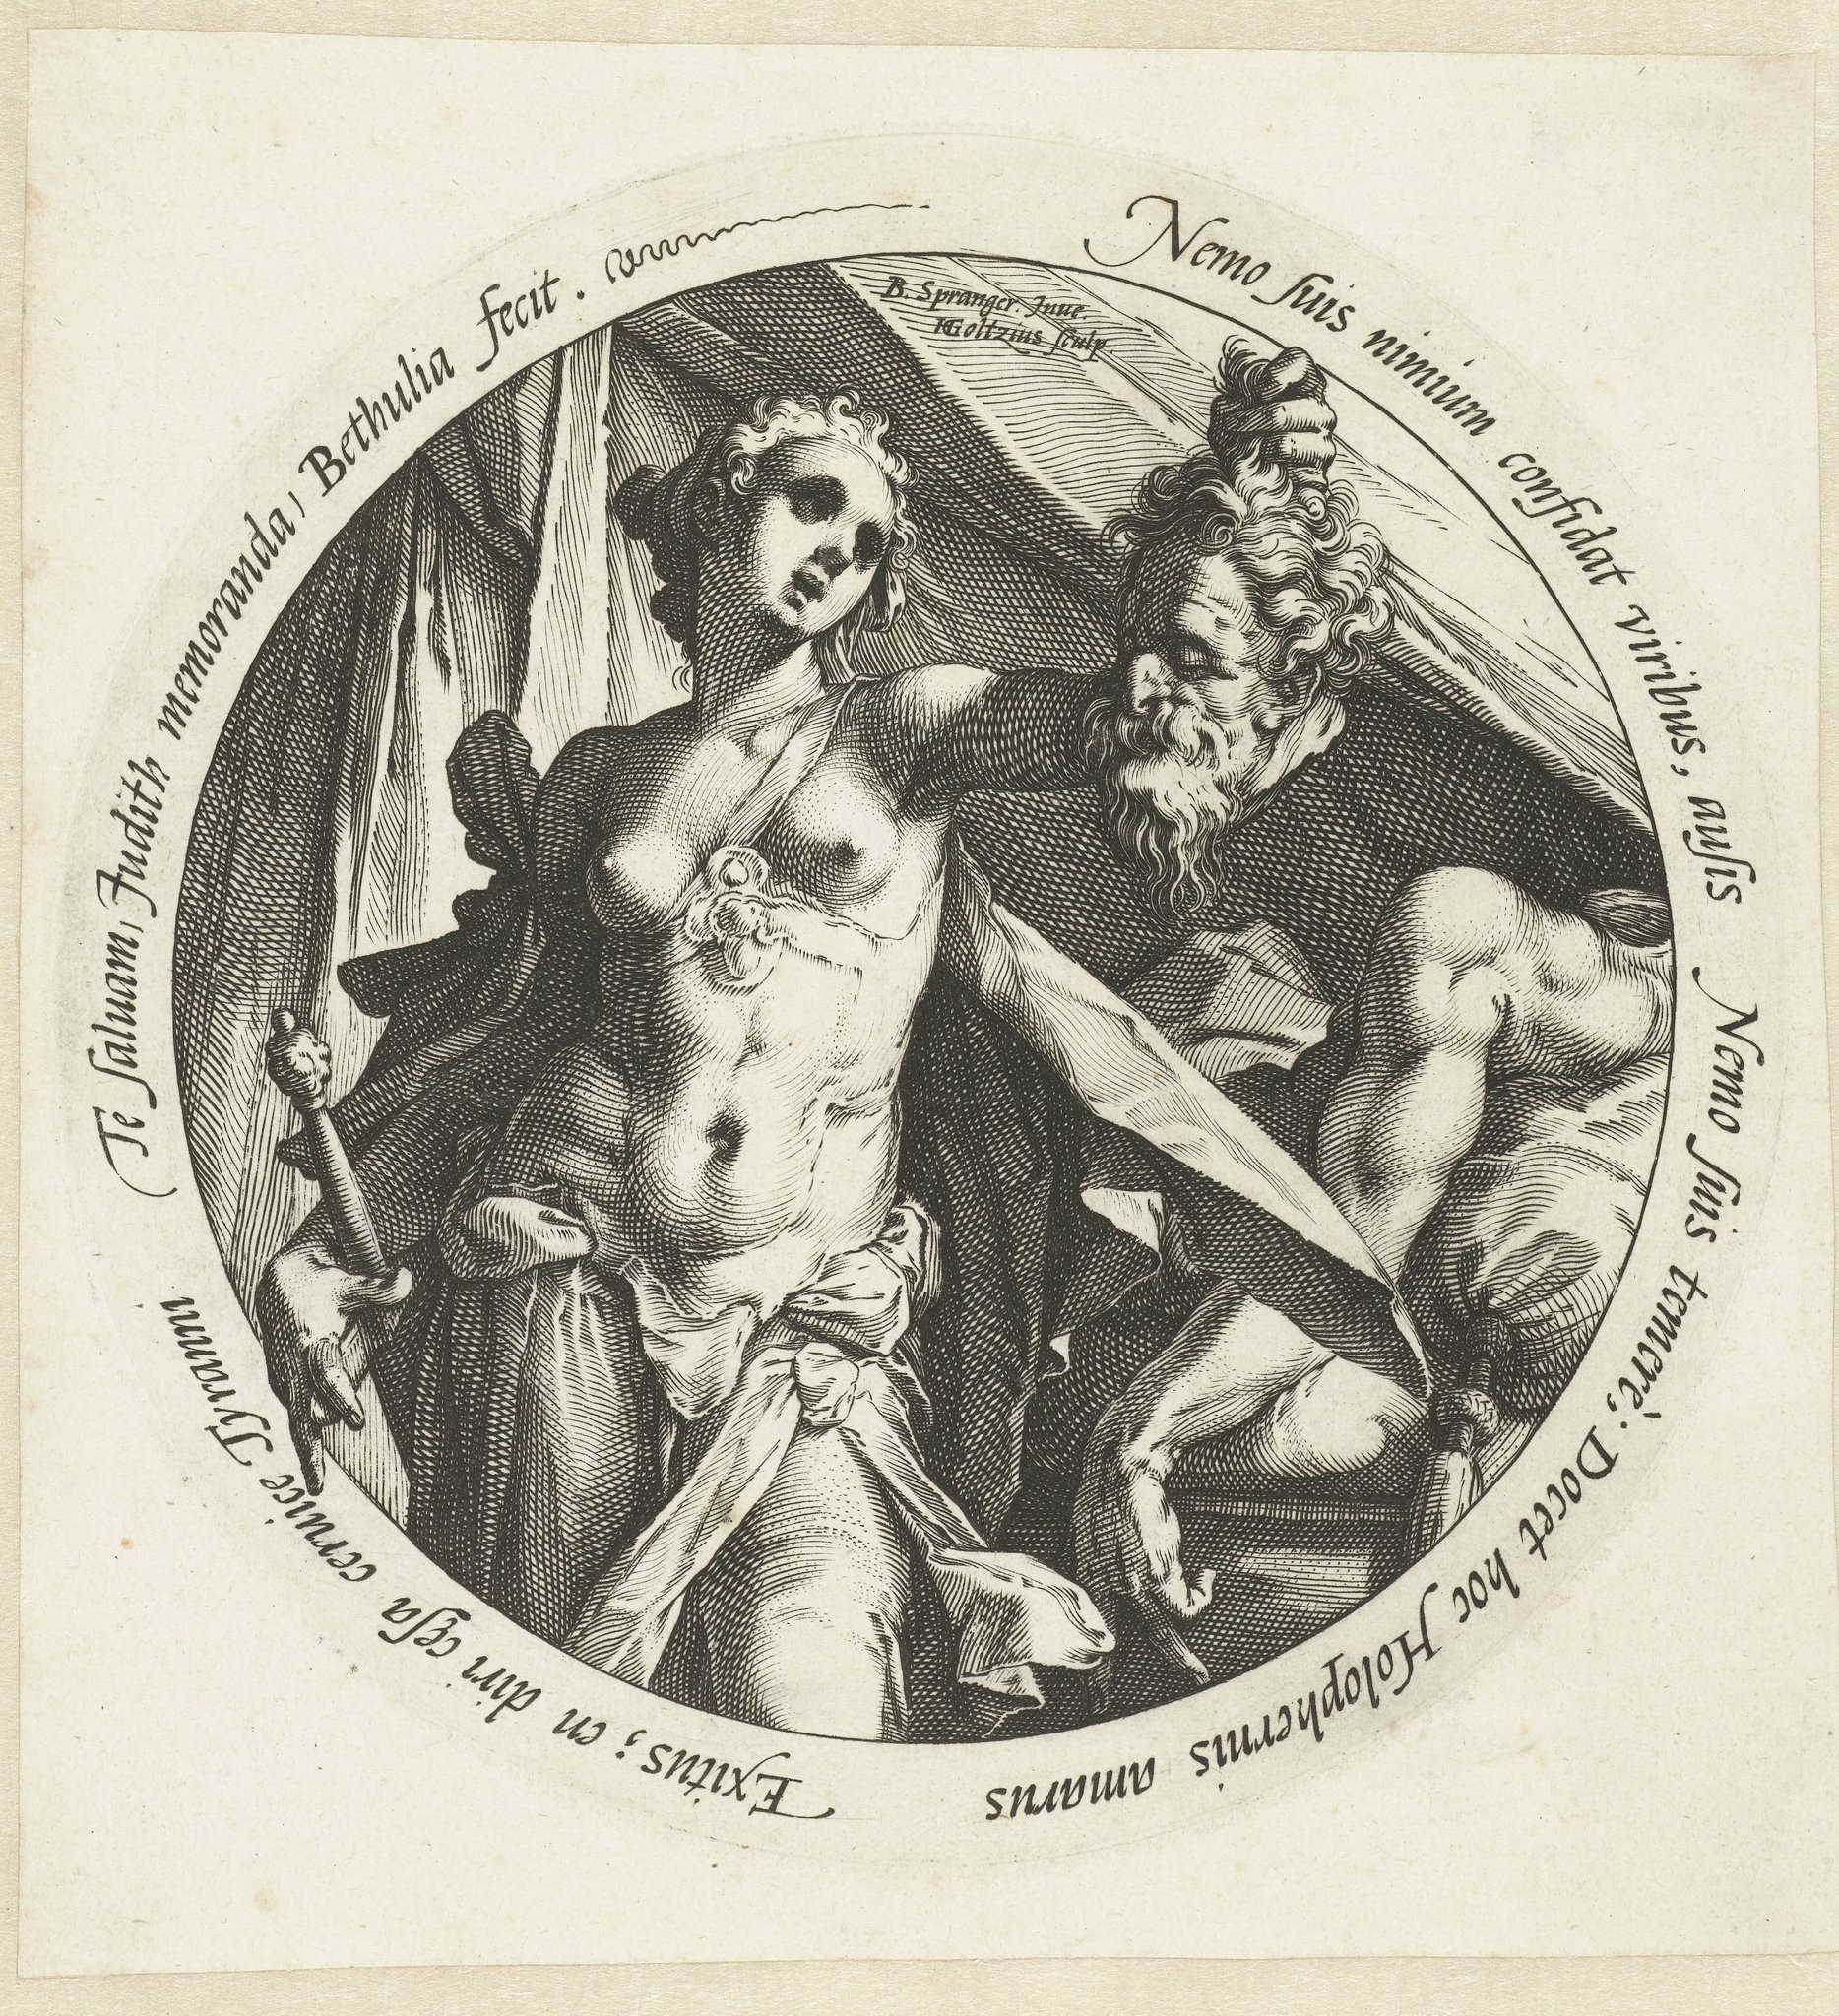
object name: print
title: Judith met het hoofd van Holofernes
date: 1584-1588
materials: paper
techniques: engraving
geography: haarlem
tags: judith with holofernes' head and the sword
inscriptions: collector's mark: Lugt 2228a, collector's mark: Lugt 240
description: Ronde voorstelling van Judith, staand bij het bed van Holofernes met zijn hoofd in haar linkerhand. Om de voorstelling een randschrift in Latijn.